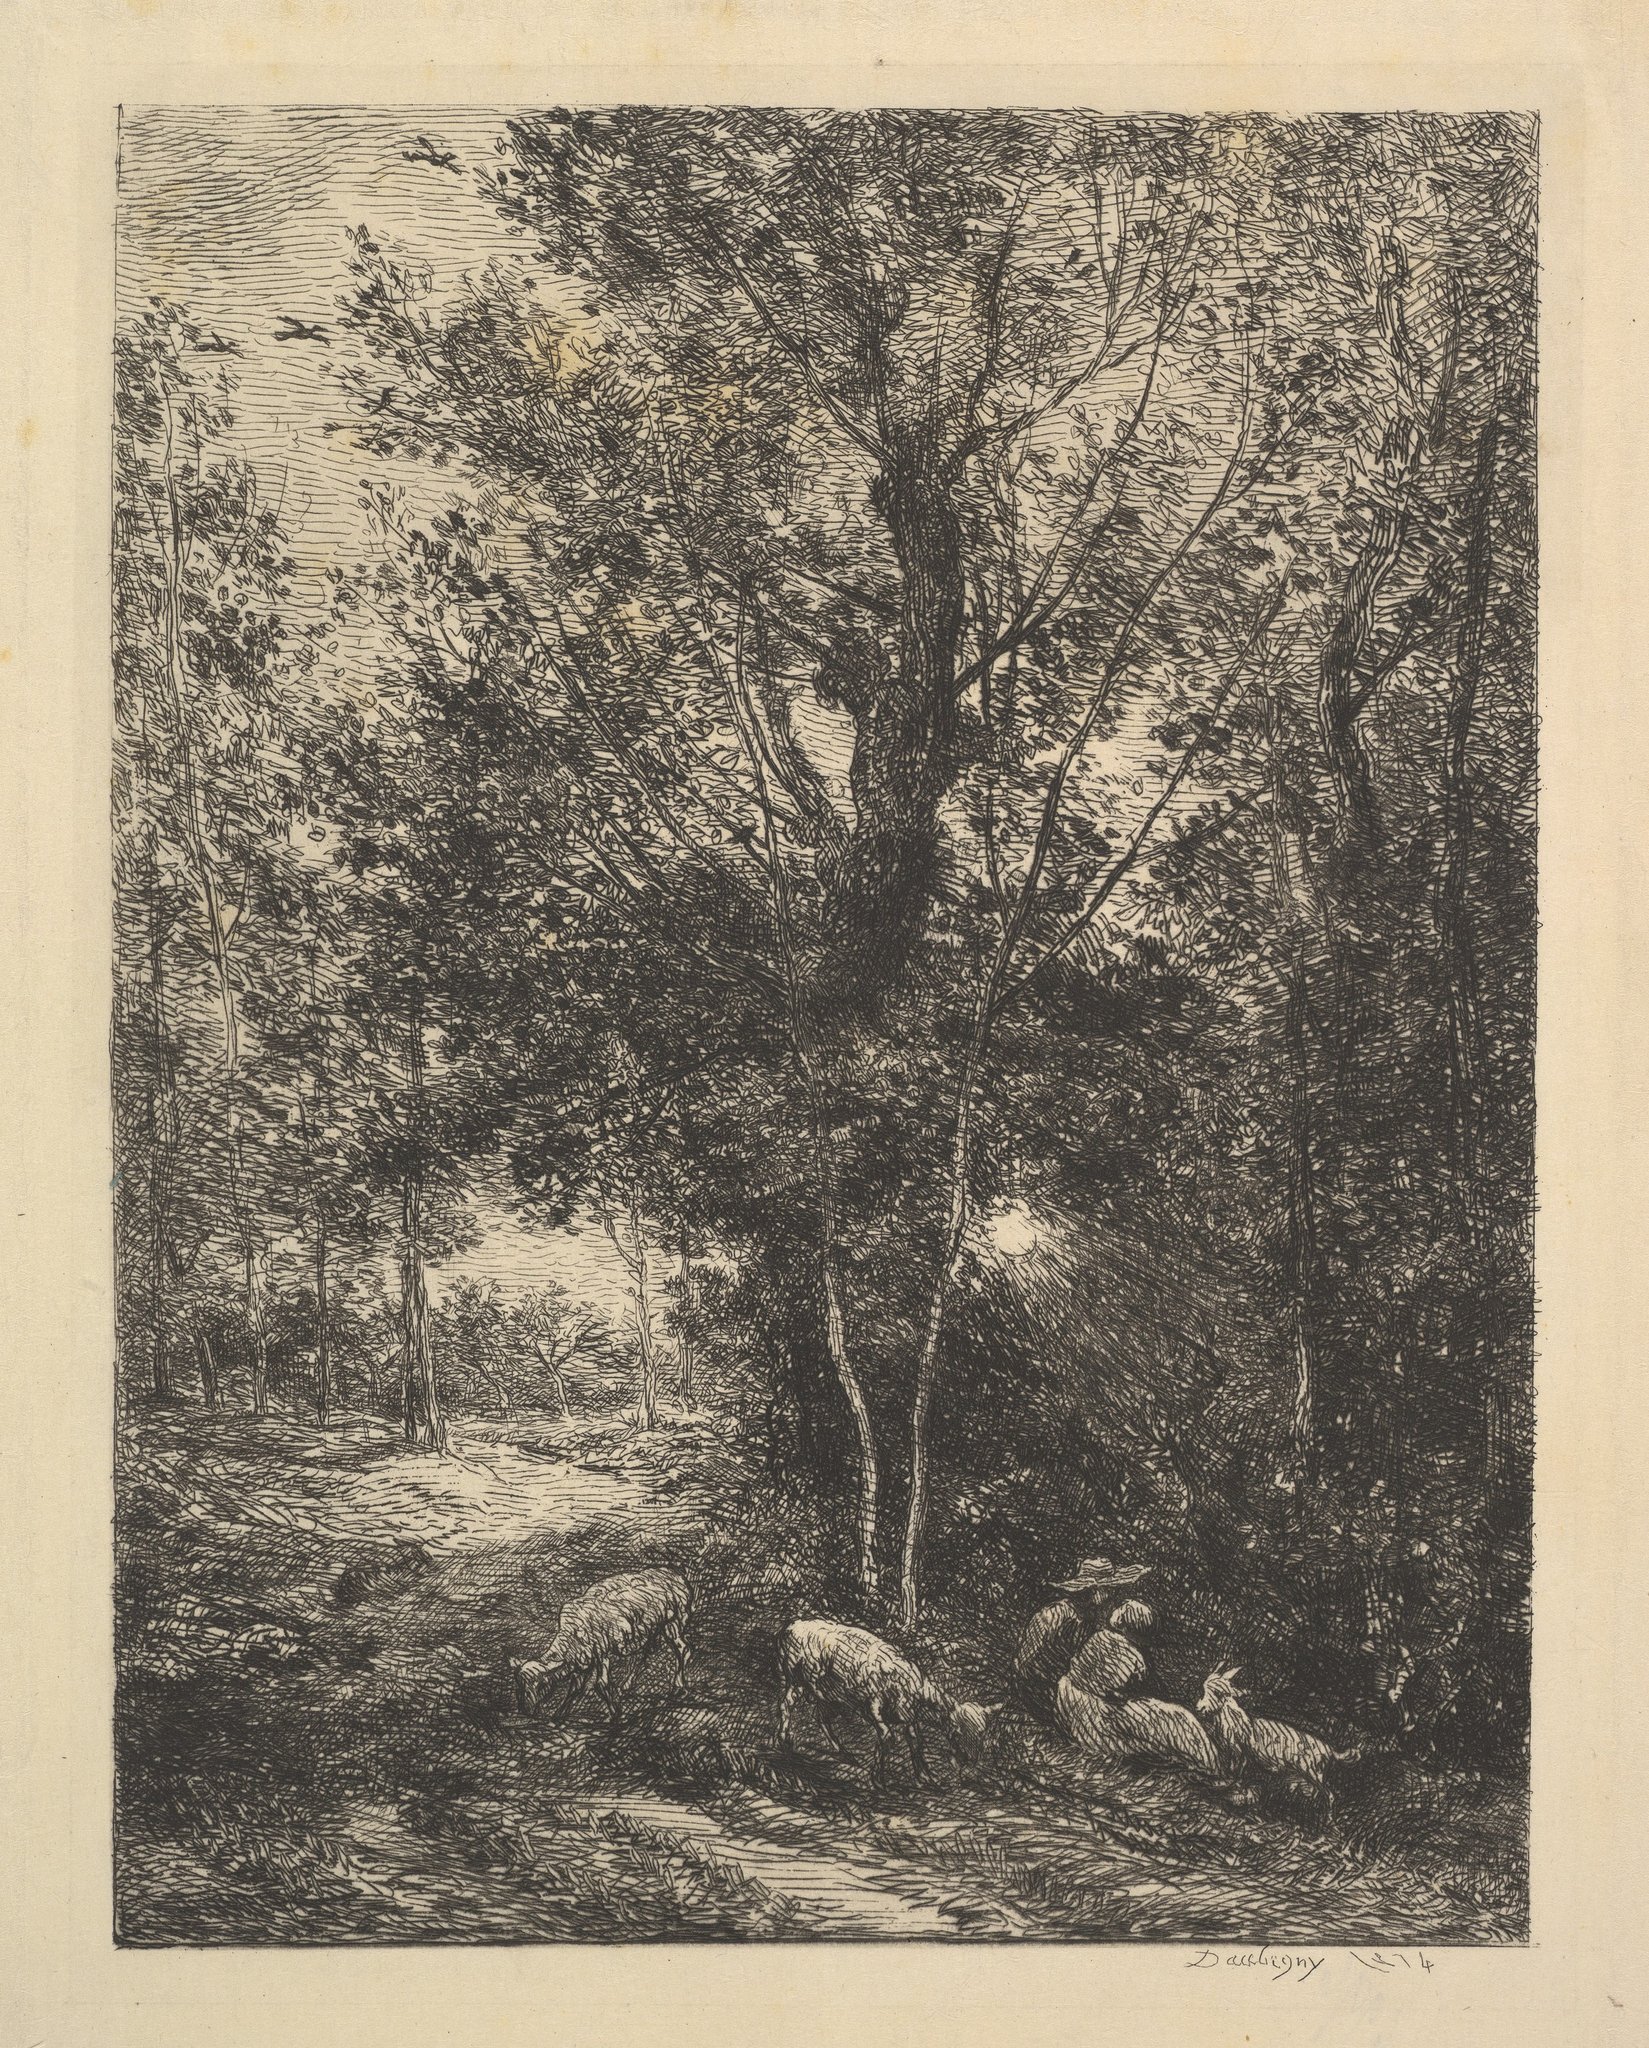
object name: print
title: Shepherd and Shepherdess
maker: charles-françois daubigny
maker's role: artist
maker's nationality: french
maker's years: 1817-1878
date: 1874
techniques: etching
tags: men,women,sheep,trees,shepherds